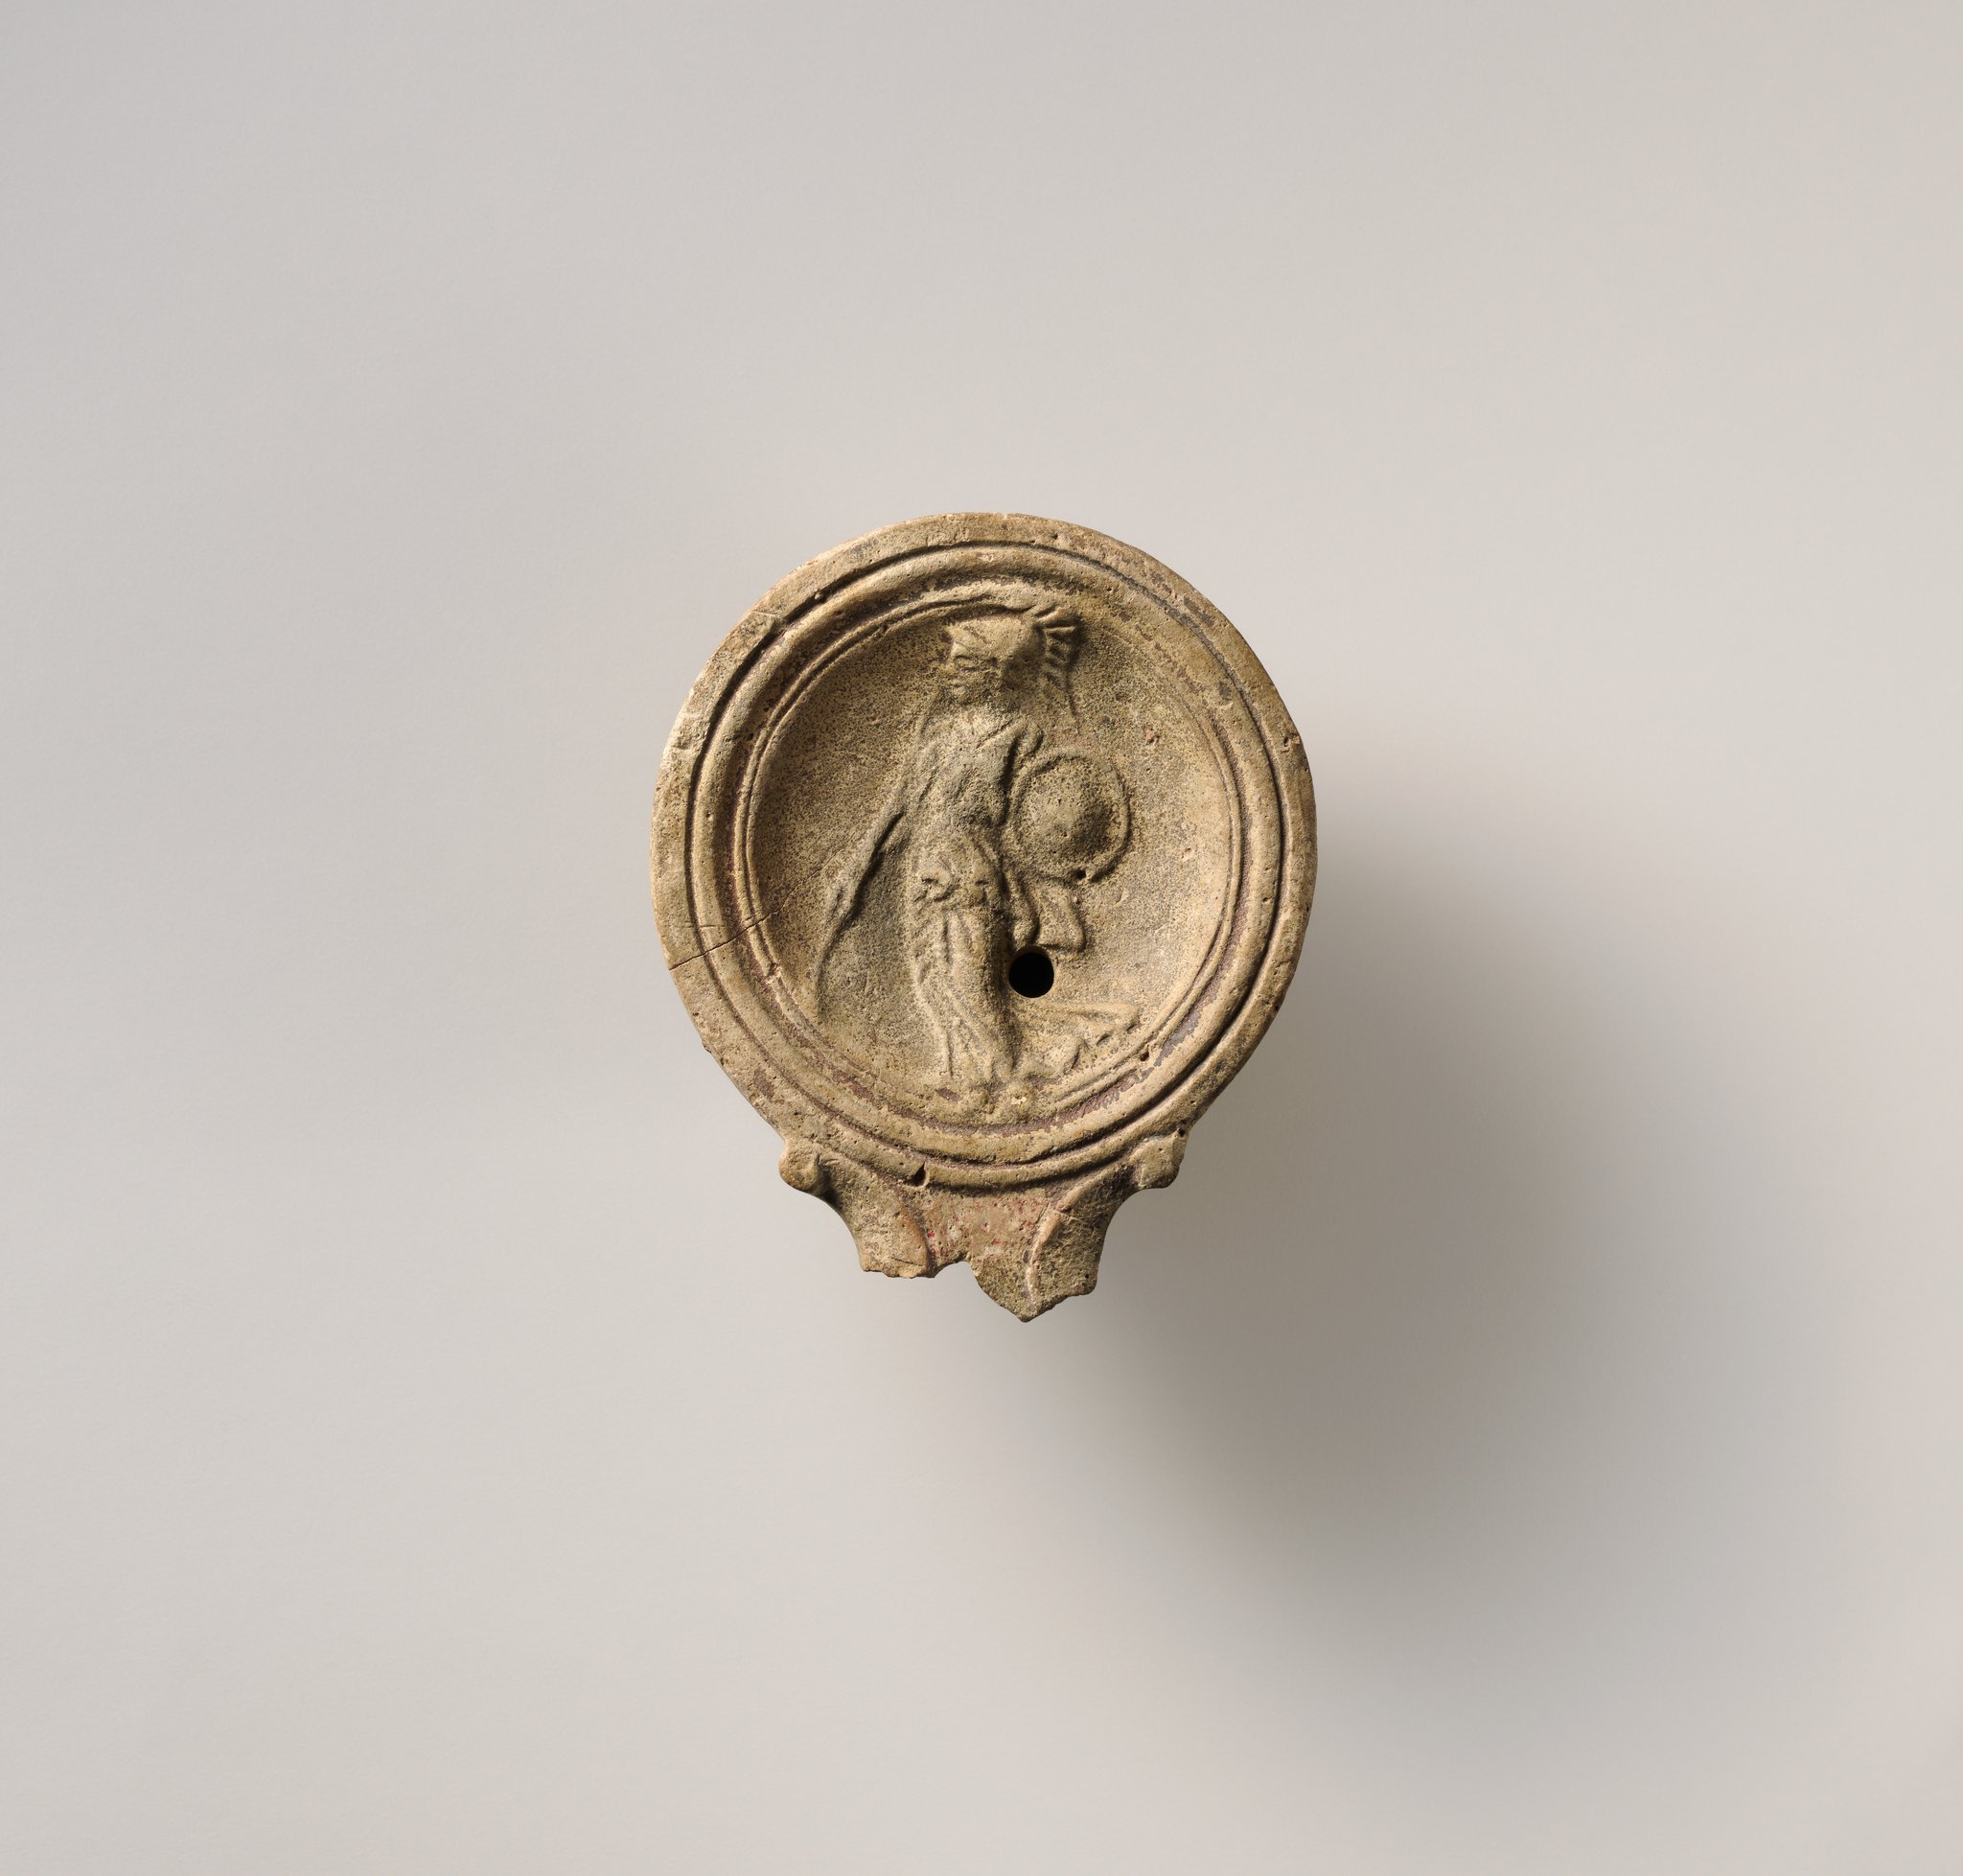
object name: lamp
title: Terracotta oil lamp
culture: roman, cypriot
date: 1-50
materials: terracotta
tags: athena